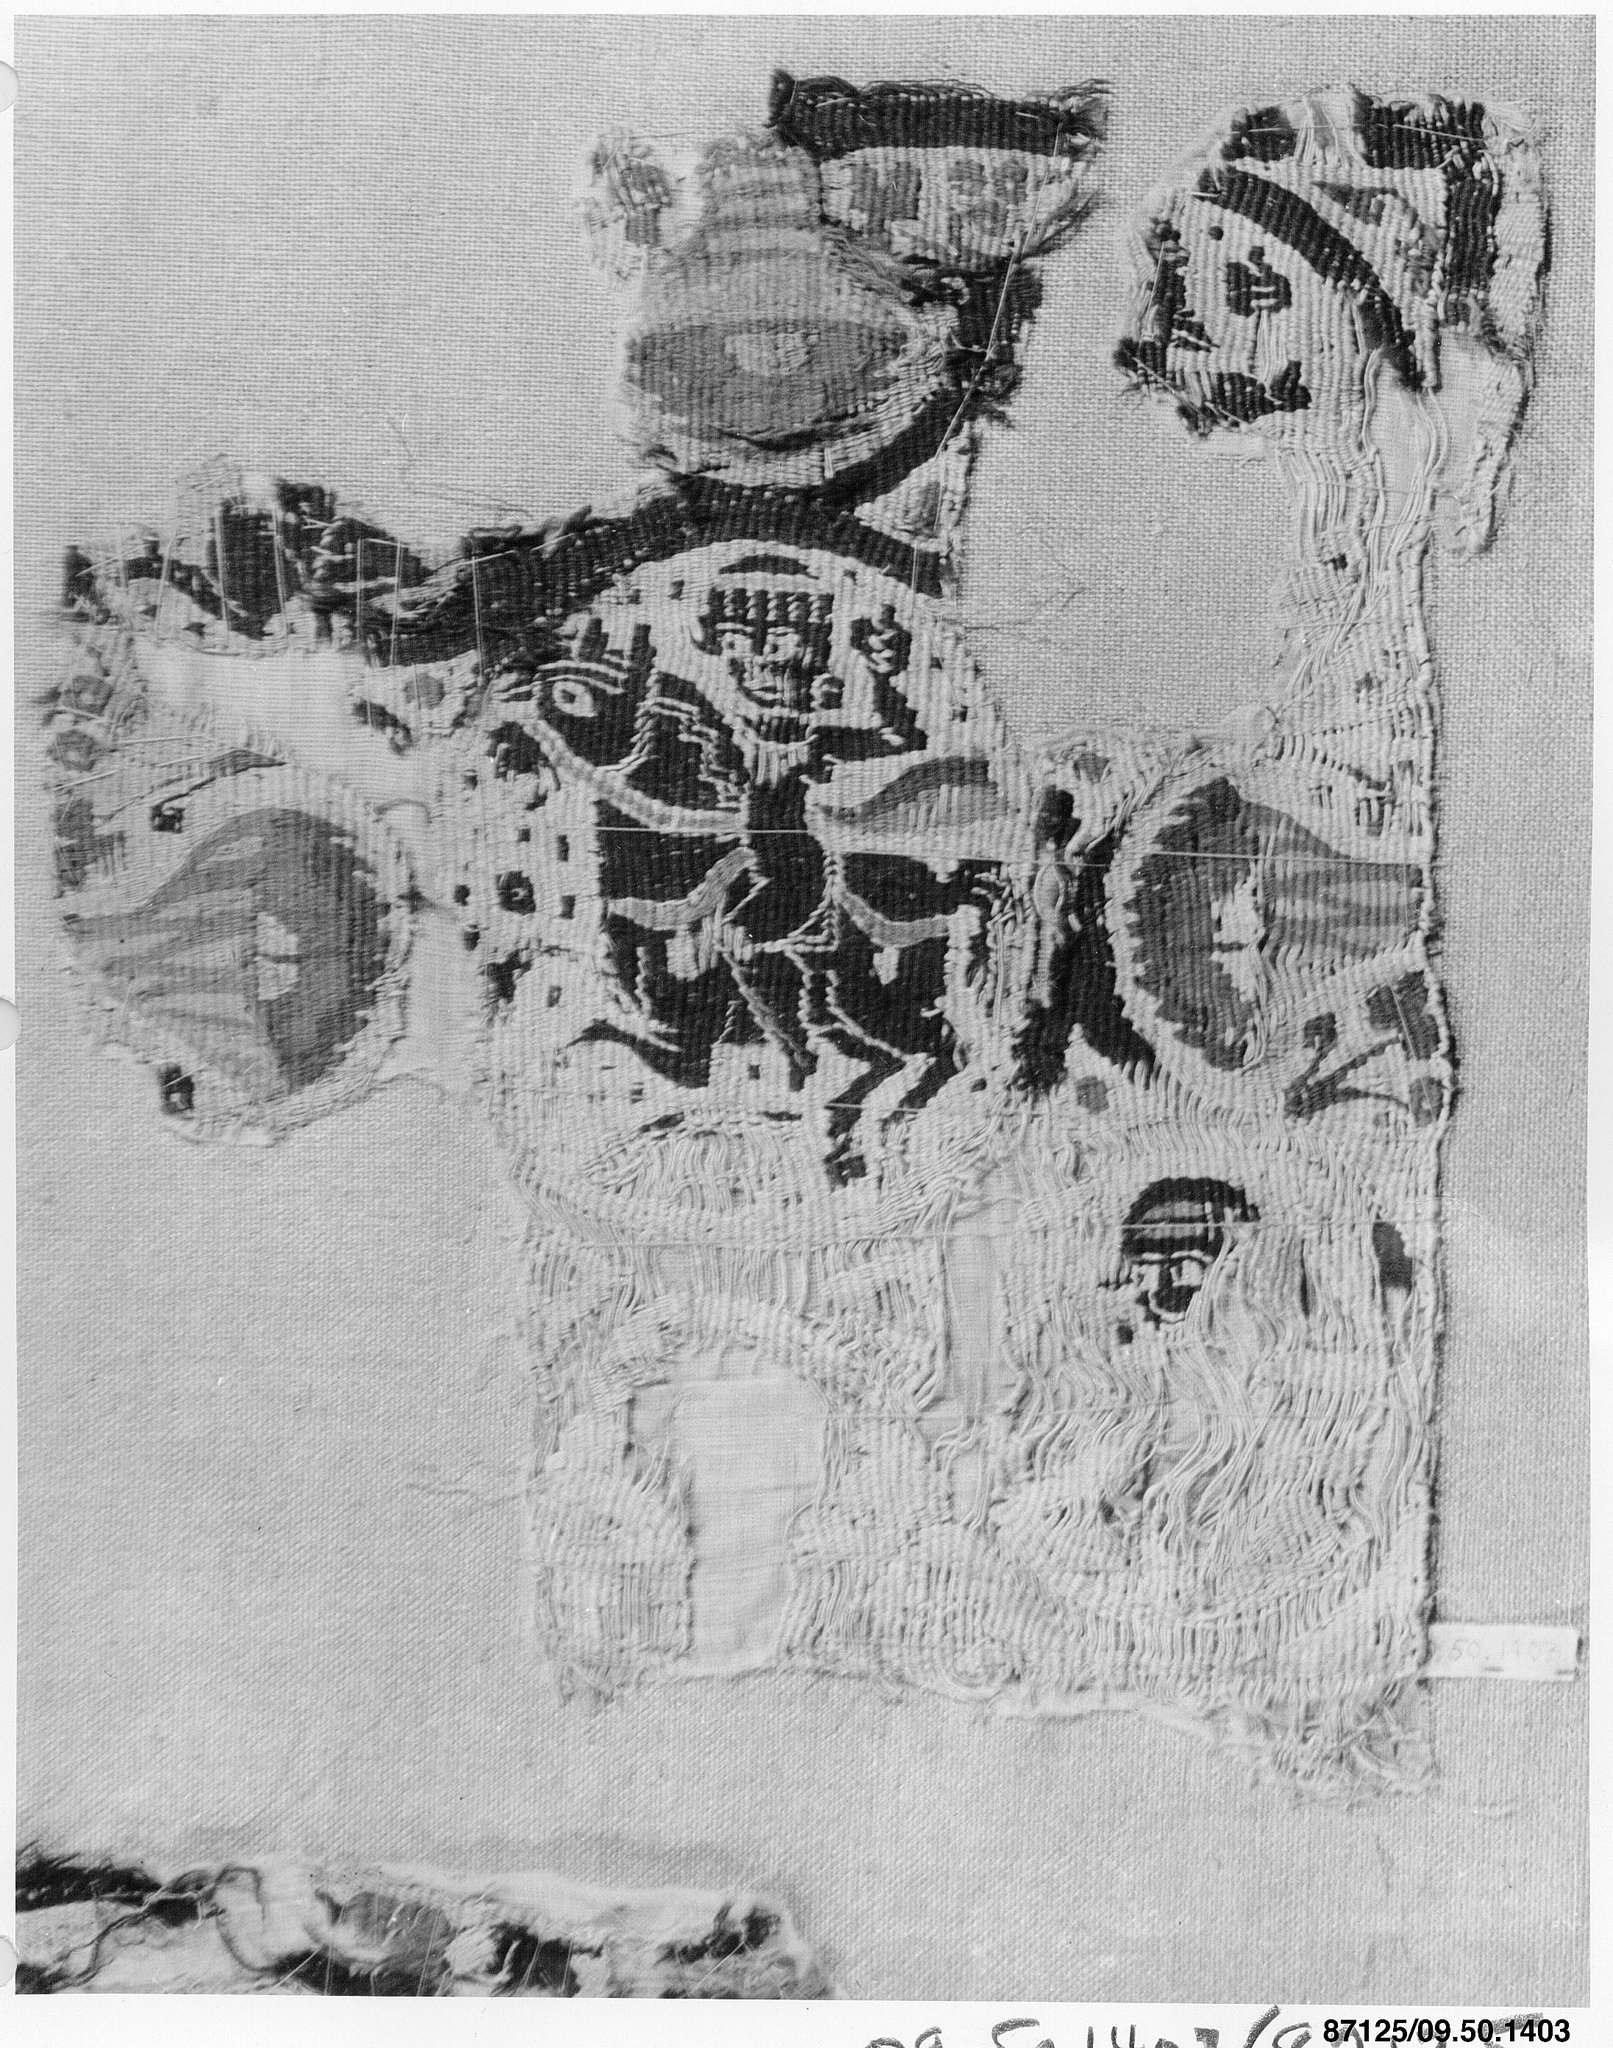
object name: square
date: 301-400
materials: linen, wool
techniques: weave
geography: egypt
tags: horses